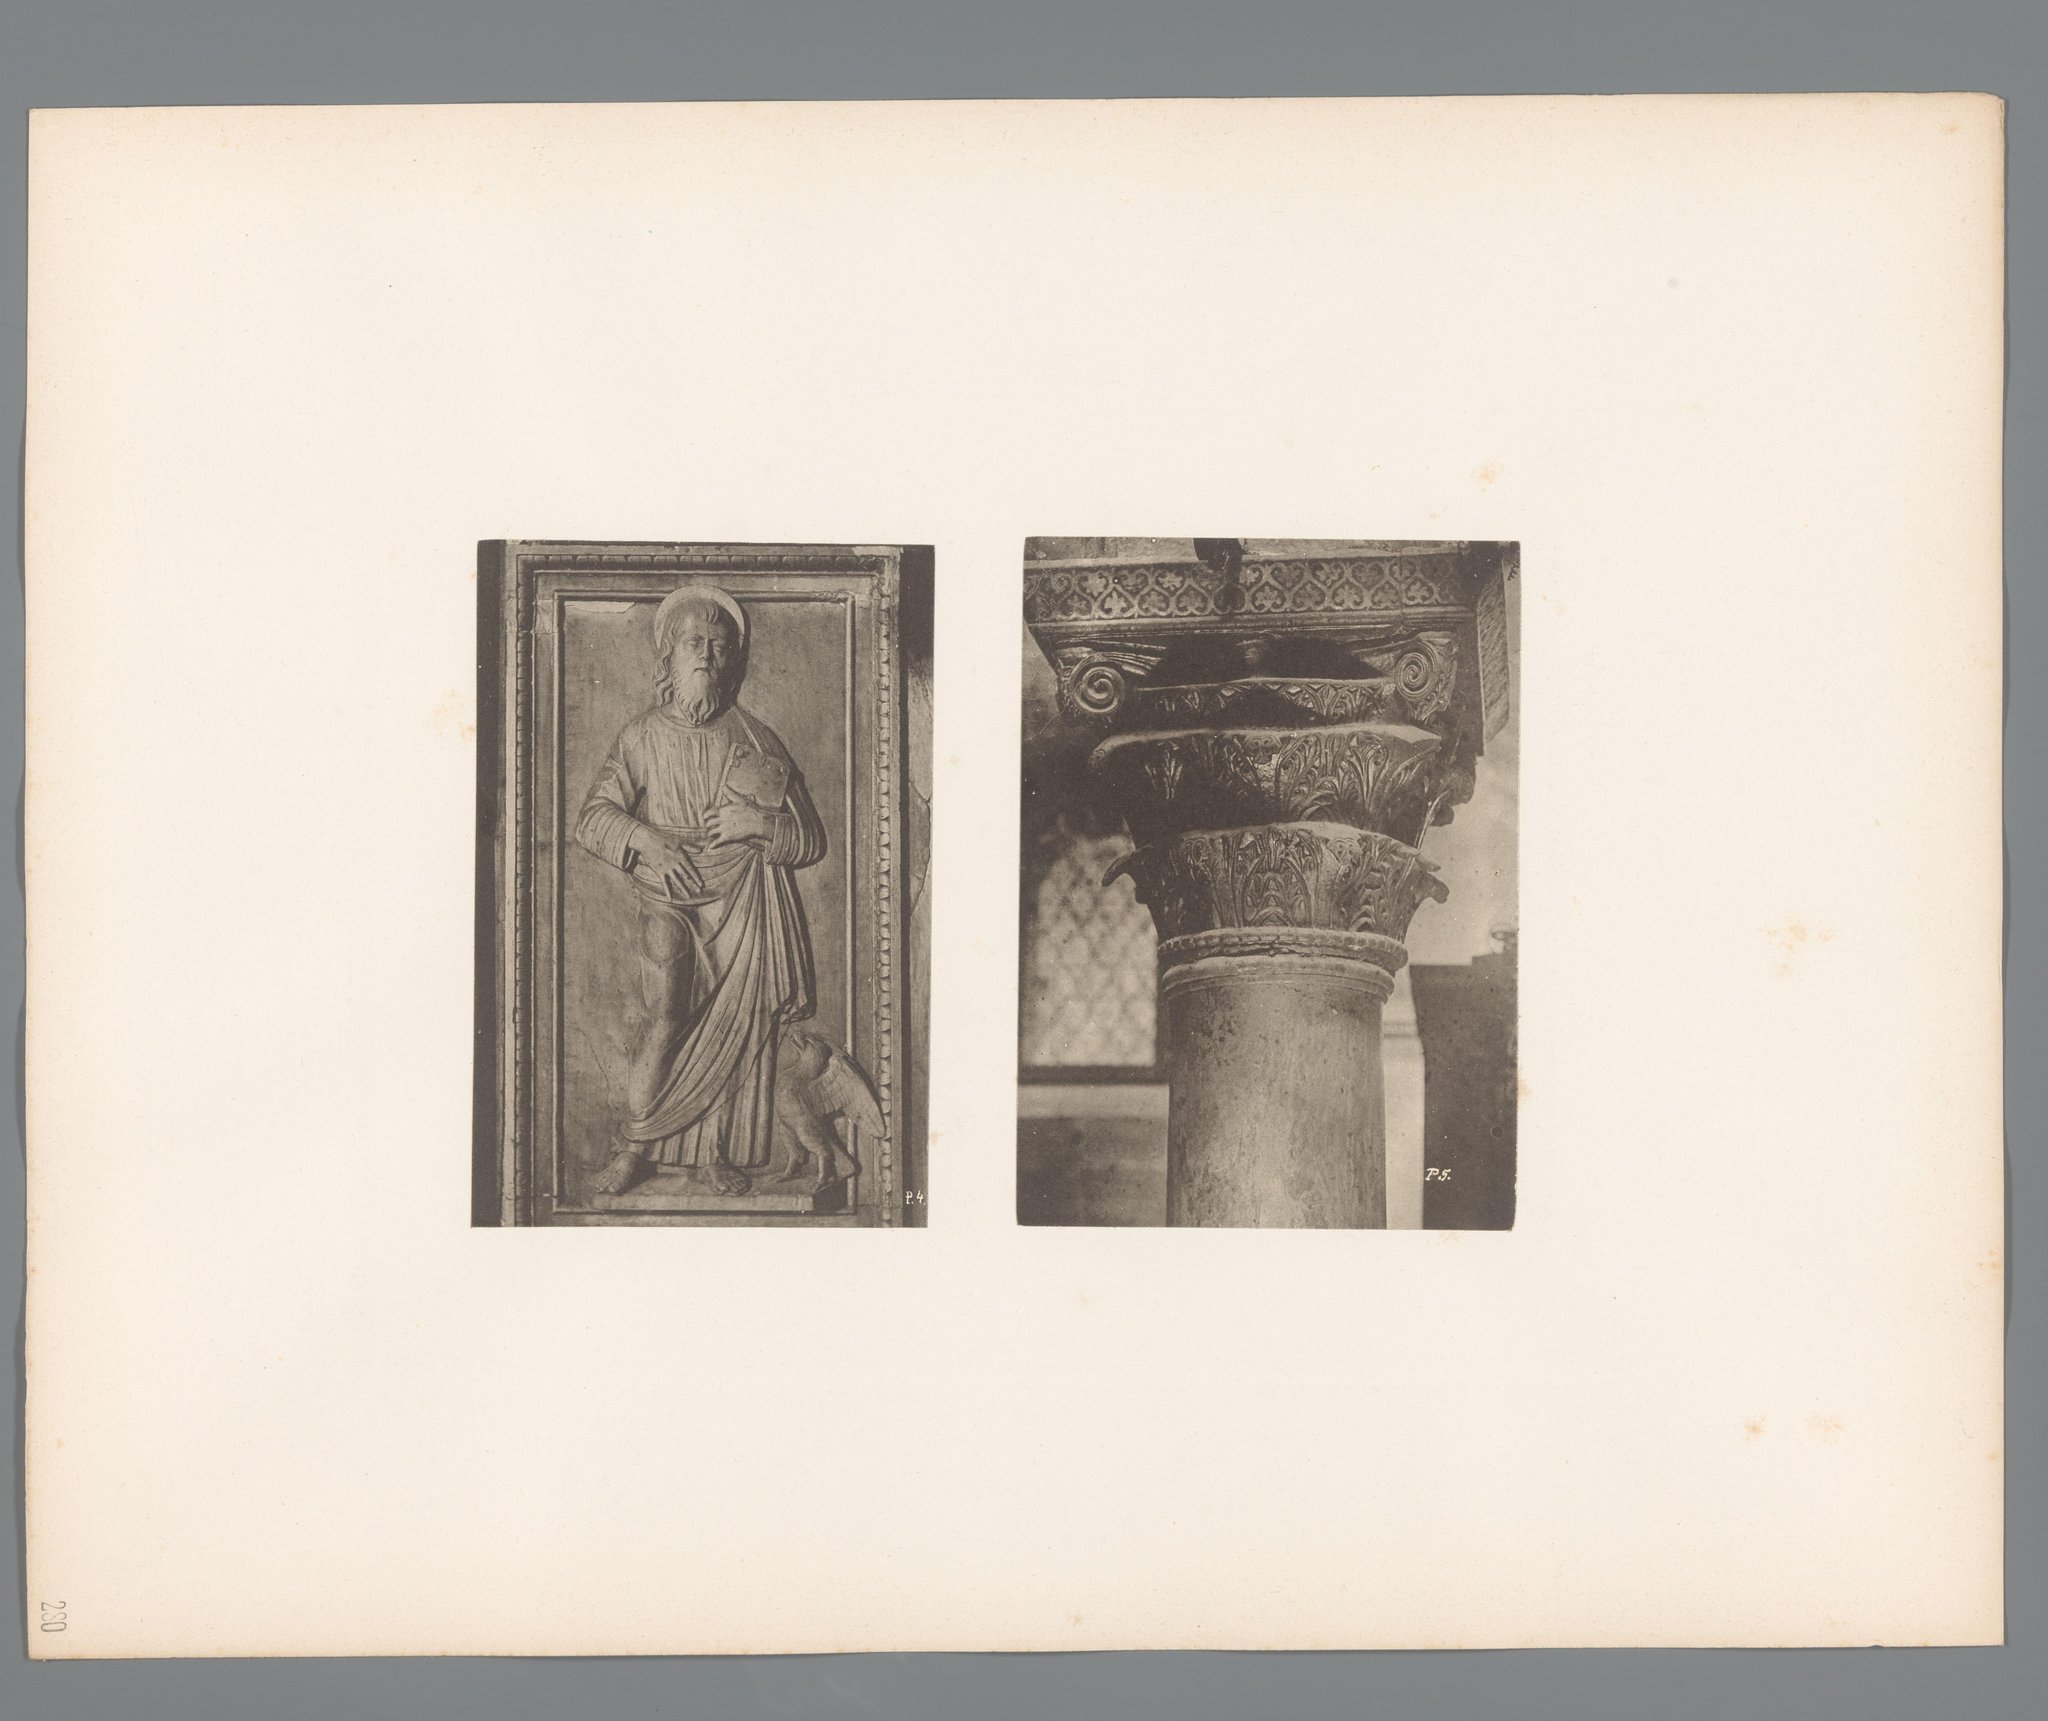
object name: photomechanical print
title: Reliëf van een heilige en een Korinthisch kapiteel van de San Marco in Venetië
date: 1880-1885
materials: paper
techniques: photograph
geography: venice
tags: capital (~ column, pillar) (+ classical art), piece of sculpture, reproduction of a piece of sculpture, corinthian order ~ architecture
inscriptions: number: ‘P.4.’, number: ‘P5.’, number: ‘280’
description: Deze prenten maken deel uit van een omslag met 58 prenten op 50 bladen.